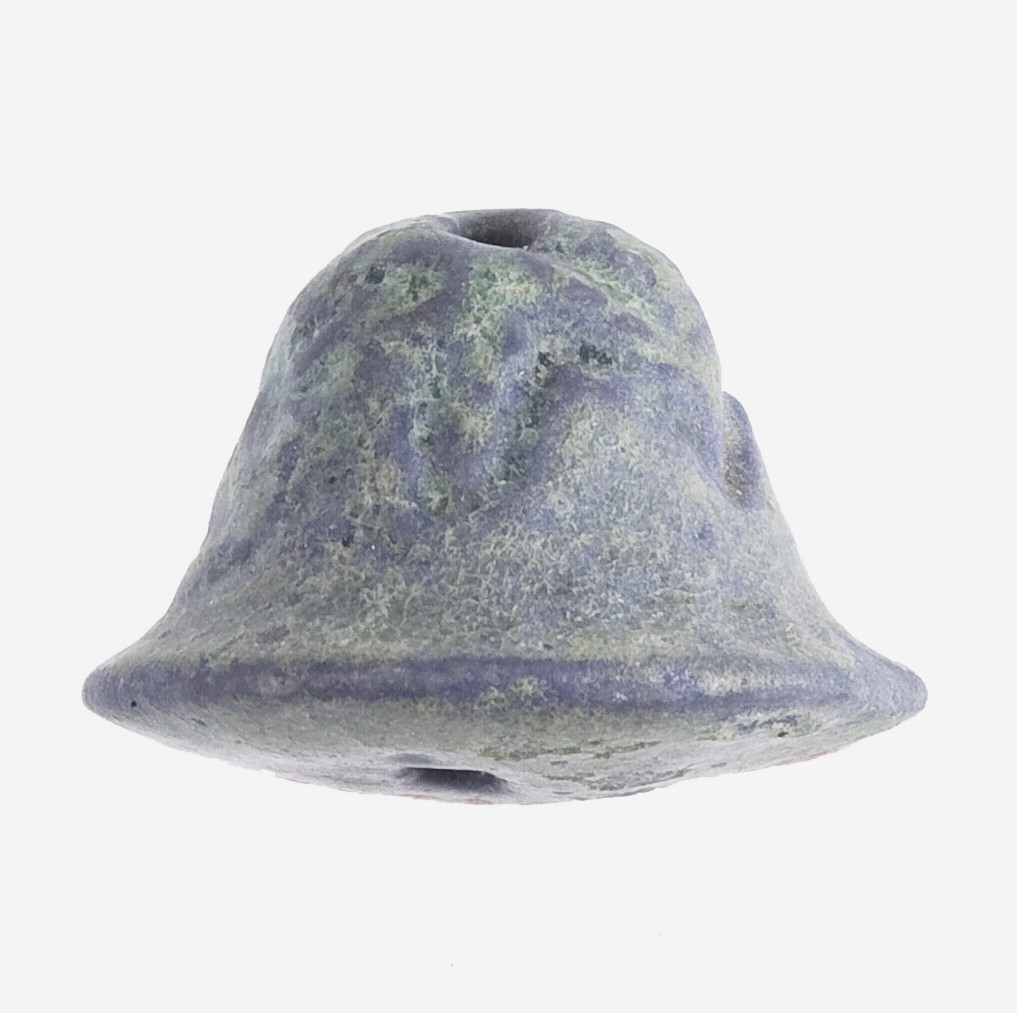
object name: pendant, umbel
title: Umbel Pendant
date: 1390-1352 BCE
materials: faience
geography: egypt